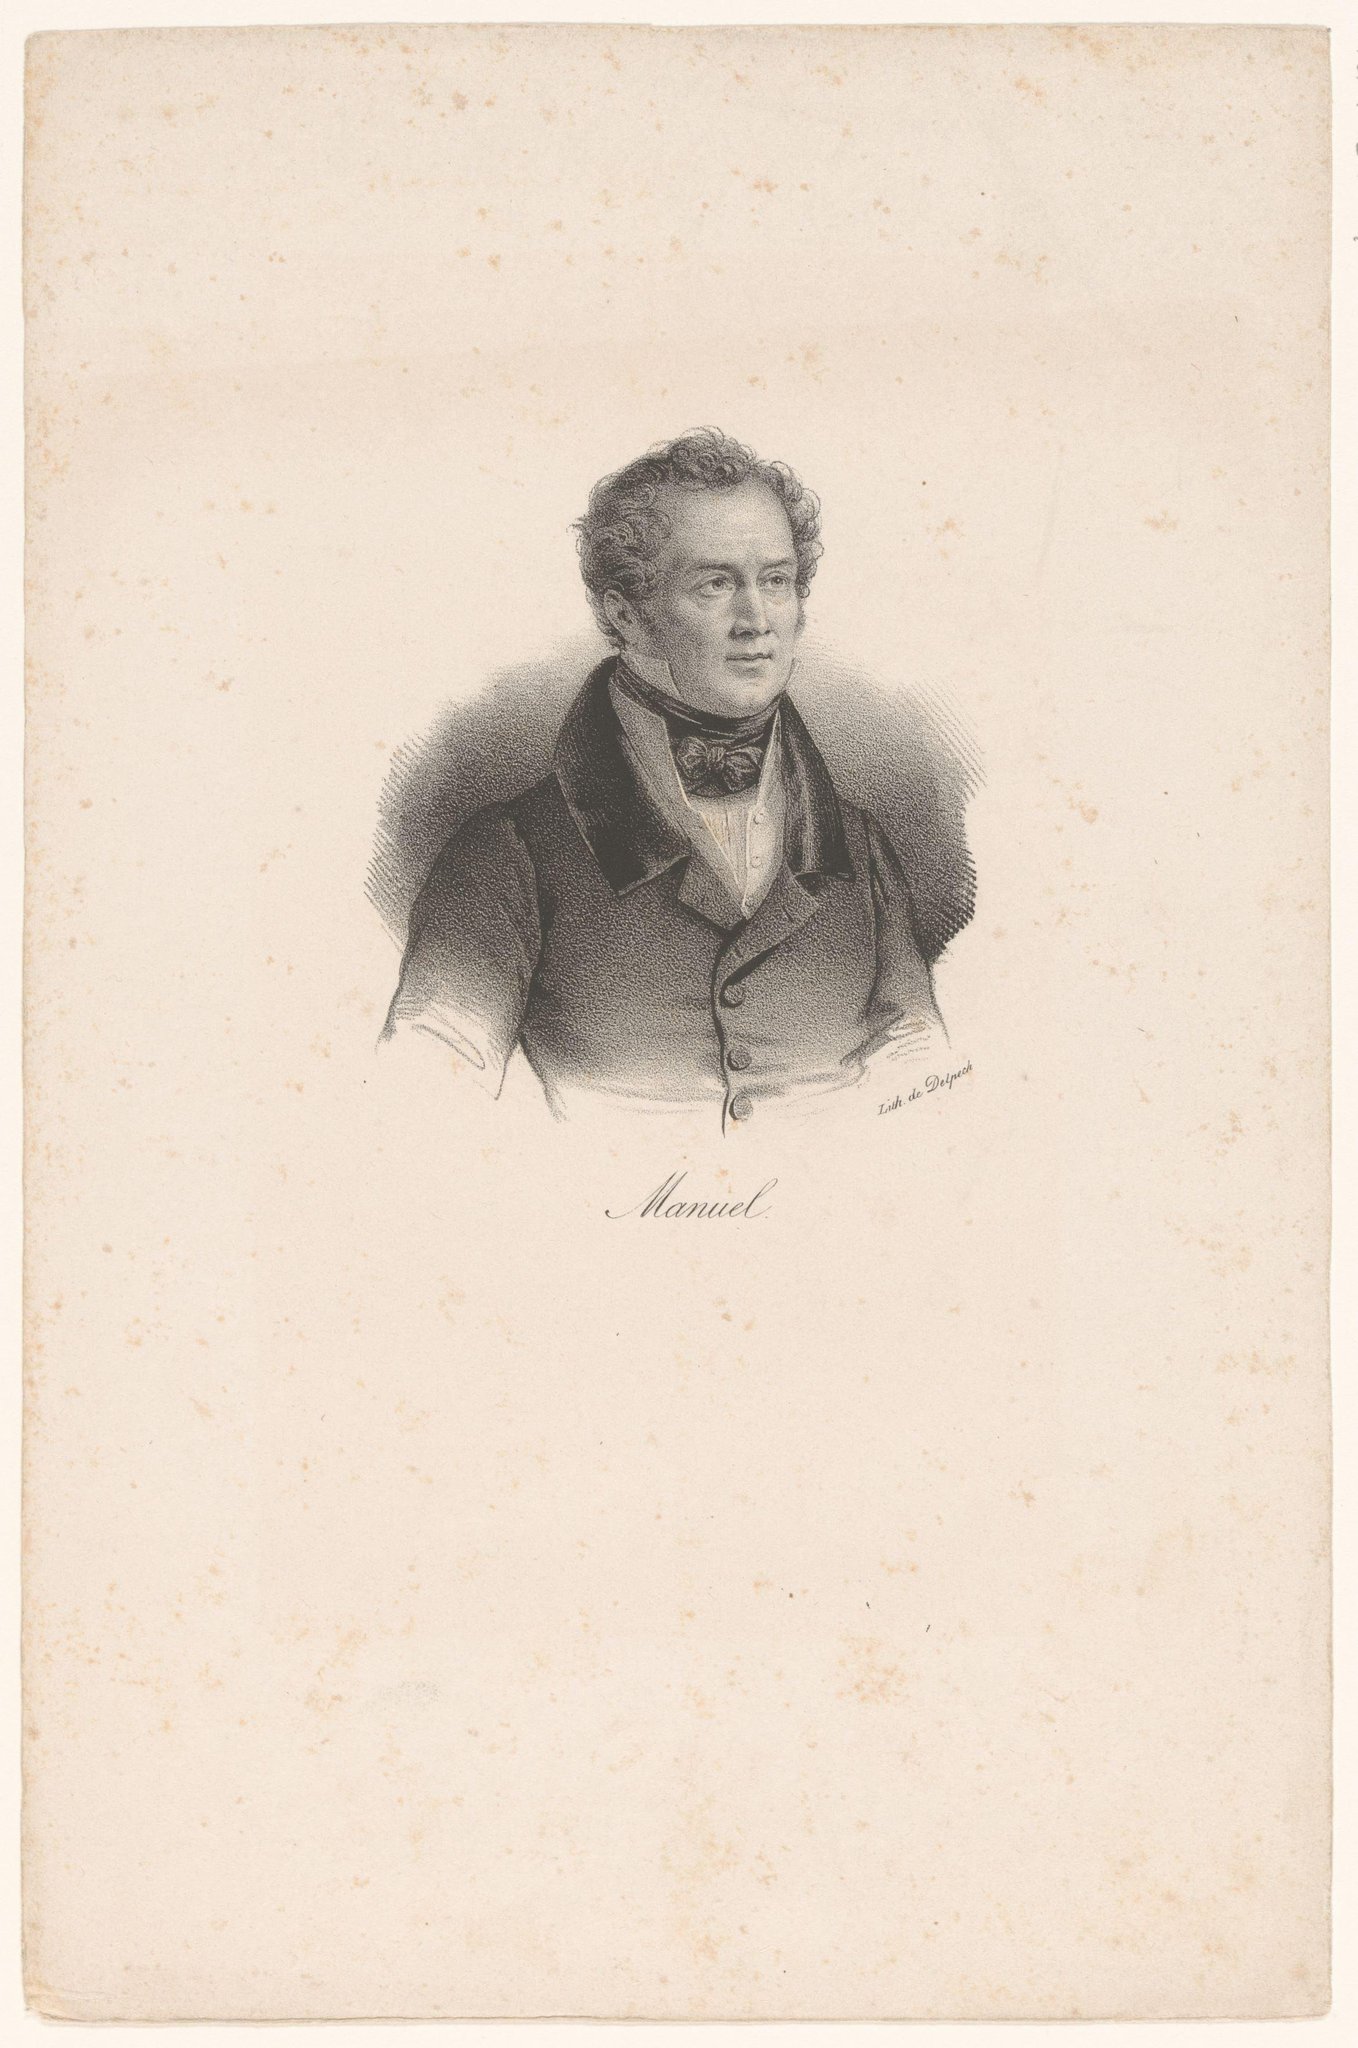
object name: print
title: Manuel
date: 1818-1842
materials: paper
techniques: lithograph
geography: paris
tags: politician, historical persons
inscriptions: collector's mark: Lugt 2228a